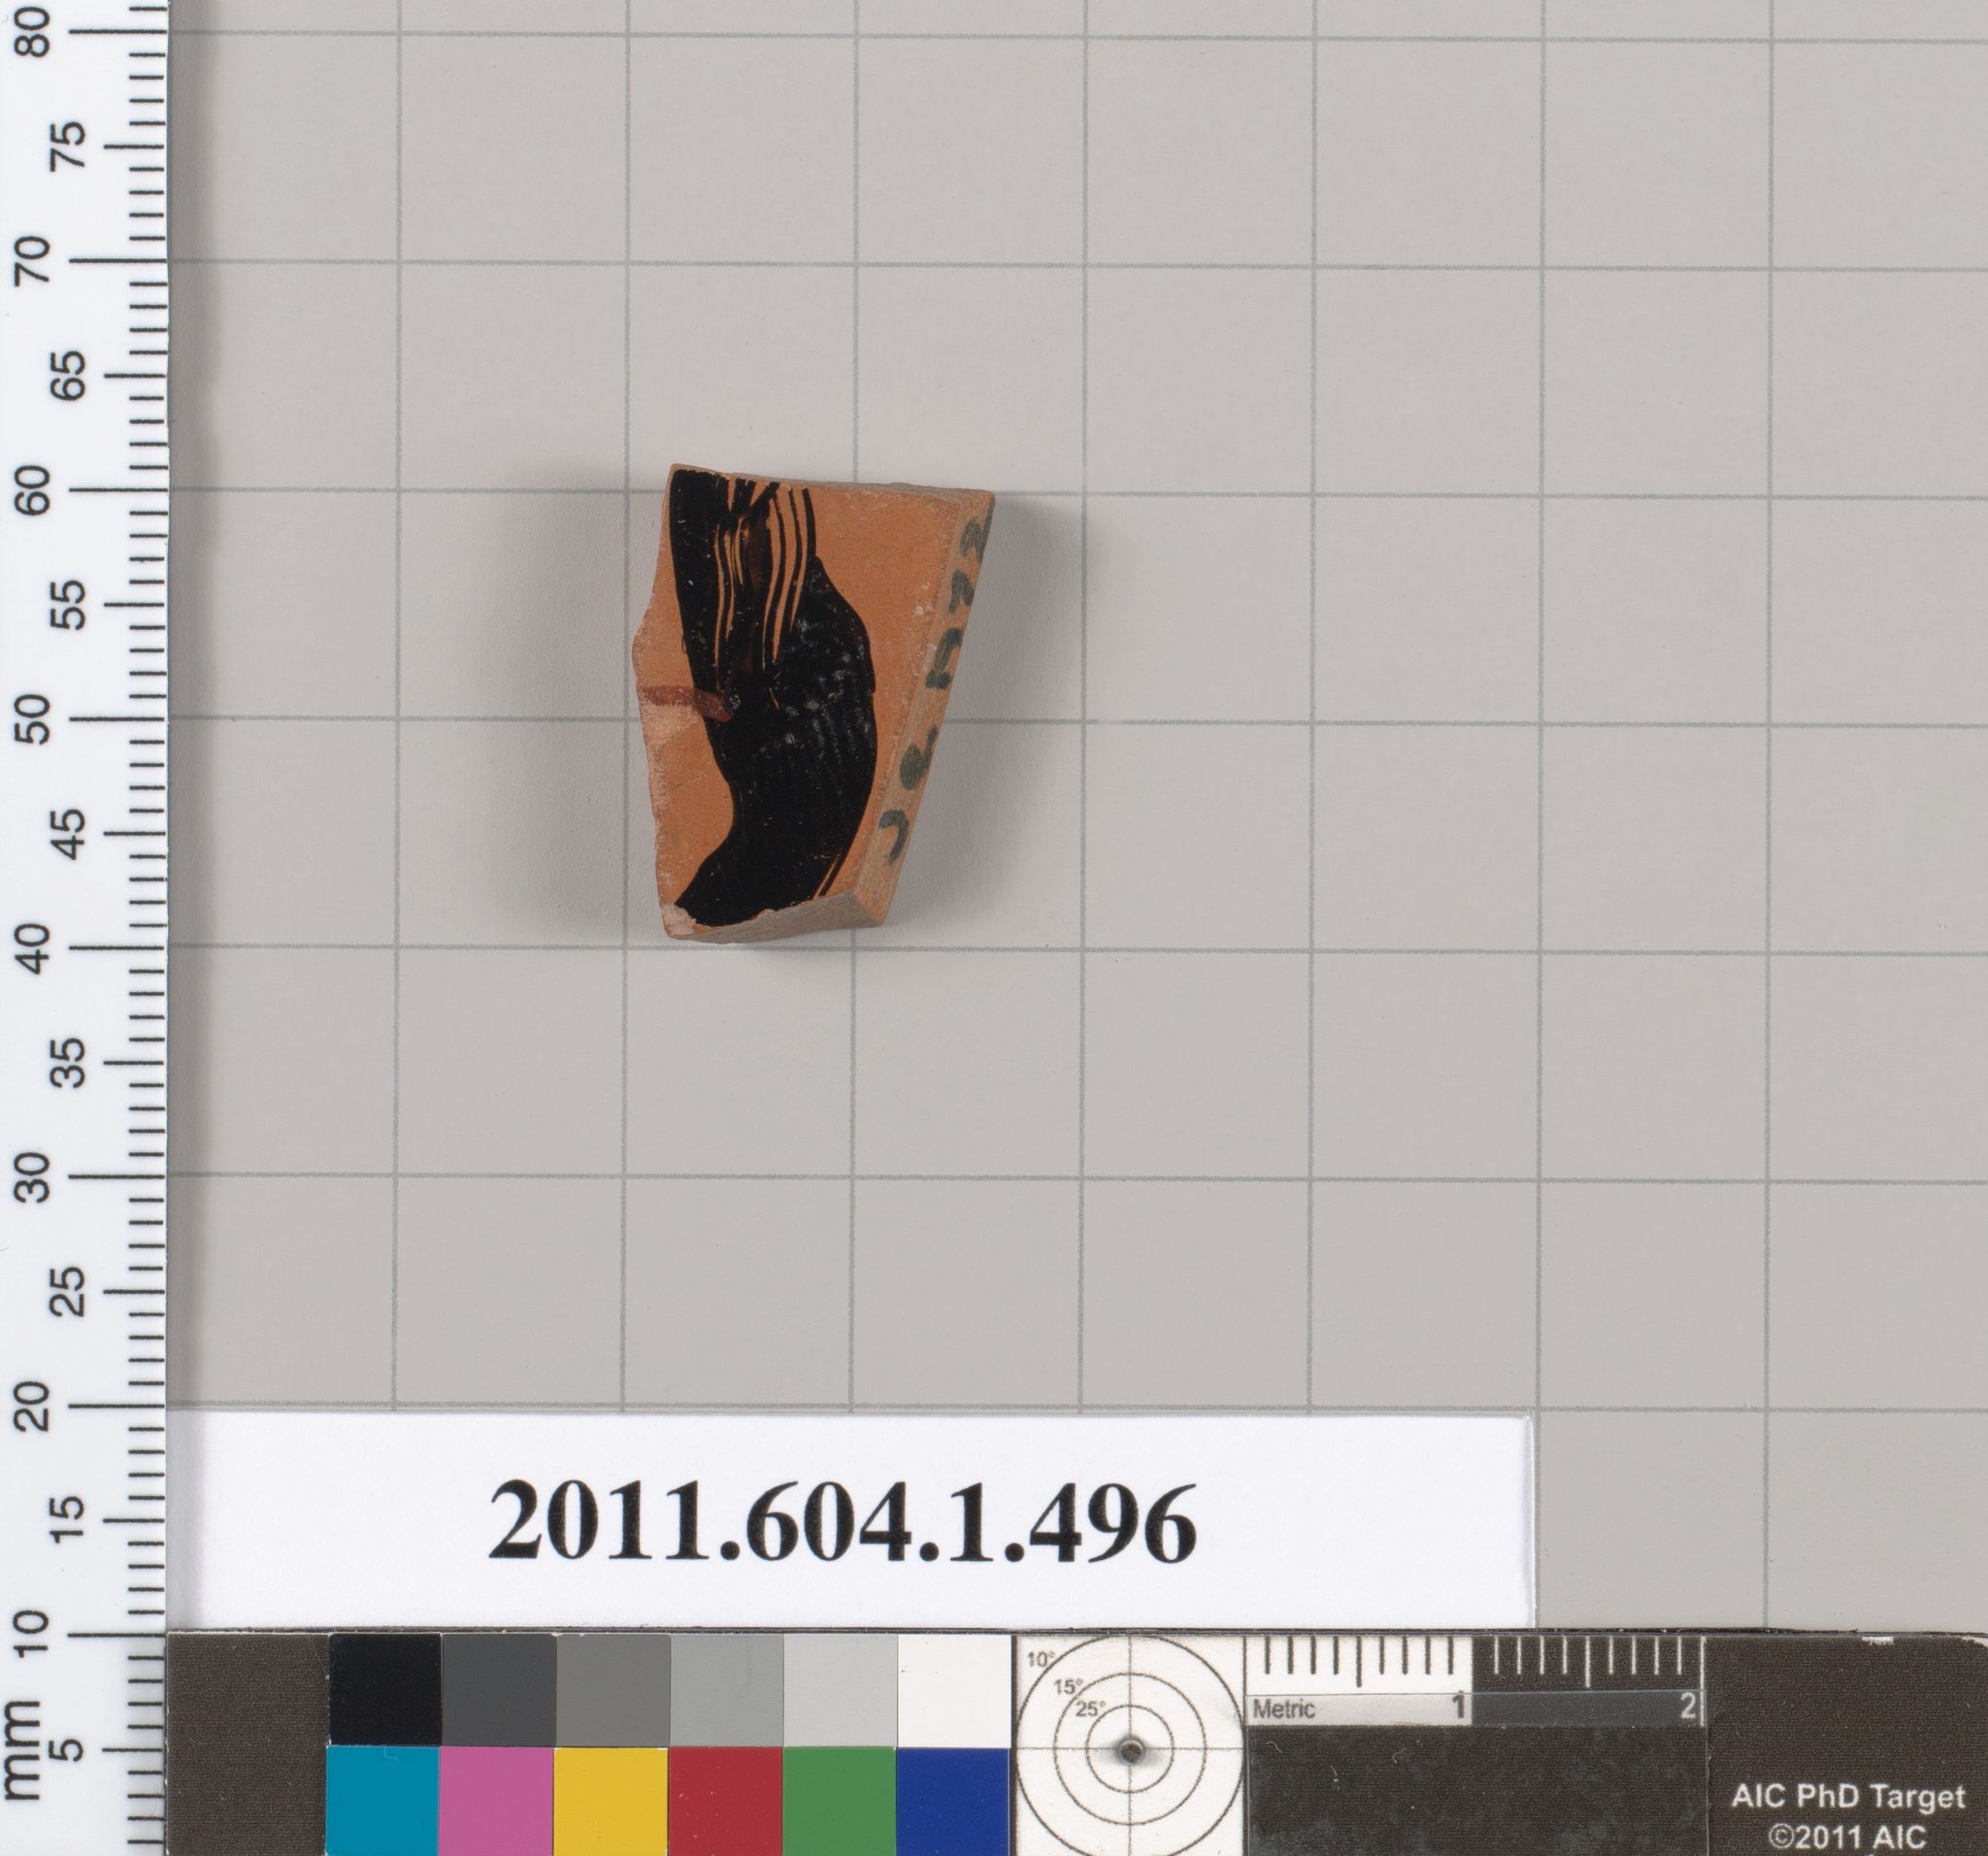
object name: kylix fragment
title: Terracotta fragment of a kylix (drinking cup)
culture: greek, attic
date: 490-480 BCE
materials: terracotta